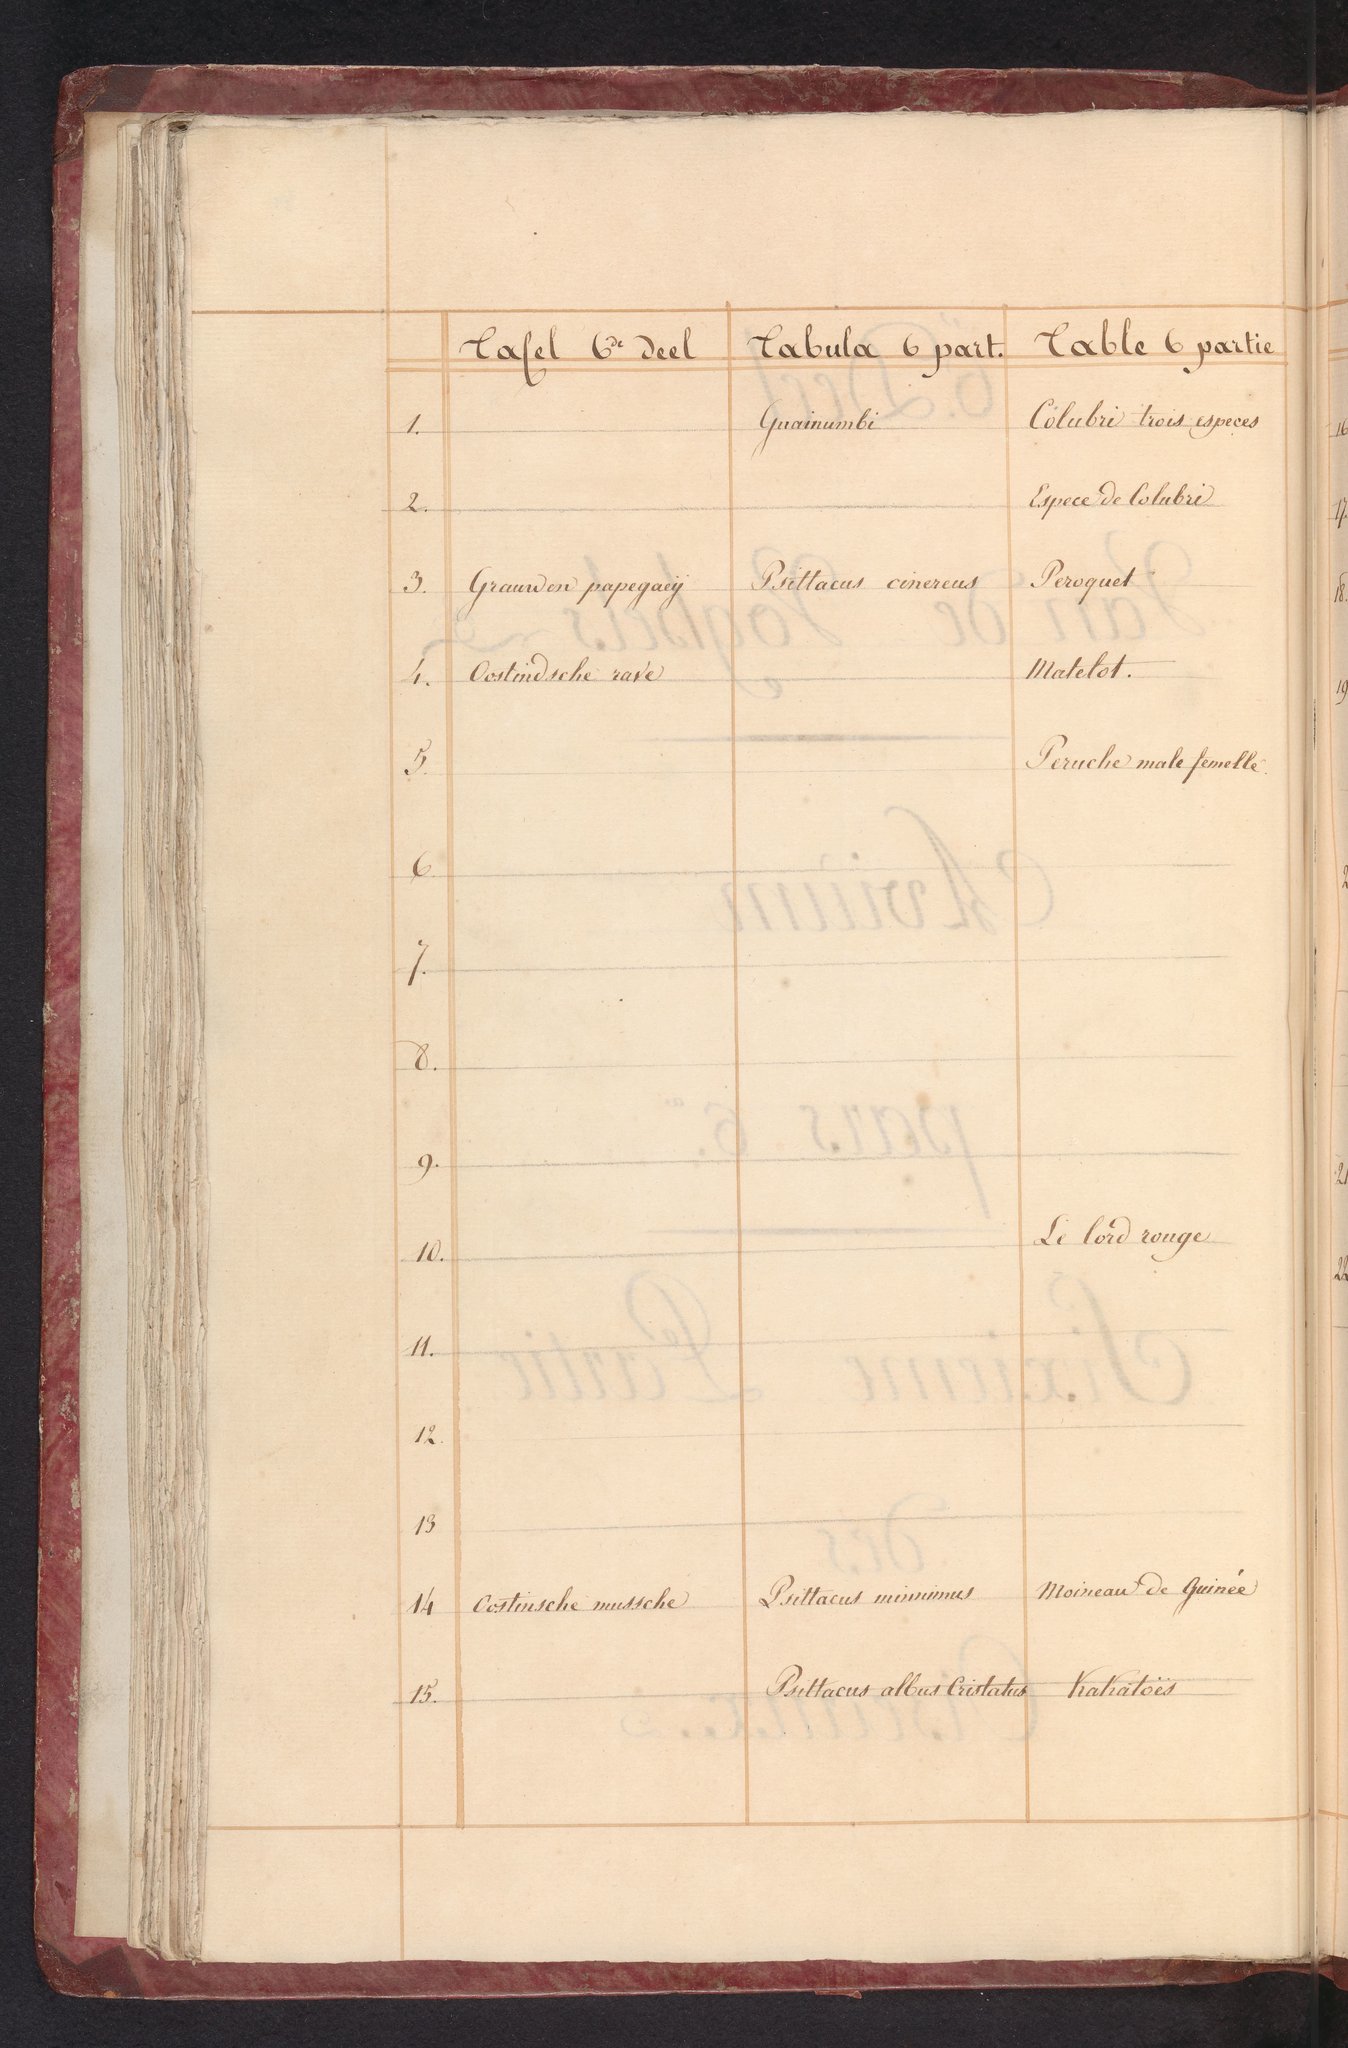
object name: manuscript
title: Tafel 6de deel / Tabula 6 part. / Table 6 partie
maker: joseph van huerne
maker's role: kunstliefhebber, mecenas, verzamelaar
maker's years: 1752-1844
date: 1809-1814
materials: ink, paper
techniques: handwriting, pen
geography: bruges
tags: handwriting, written text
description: Schema met een lijst van vogels voorgesteld in het zesde deel van de vogels: nummers 1-15. Onderdeel van het tweede album met tekeningen van vogels. Vierde van twaalf albums met tekeningen van dieren, vogels en planten bekend rond 1600, gemaakt in opdracht van keizer Rudolf II. Met toelichting in Nederlands, Latijn en Frans.